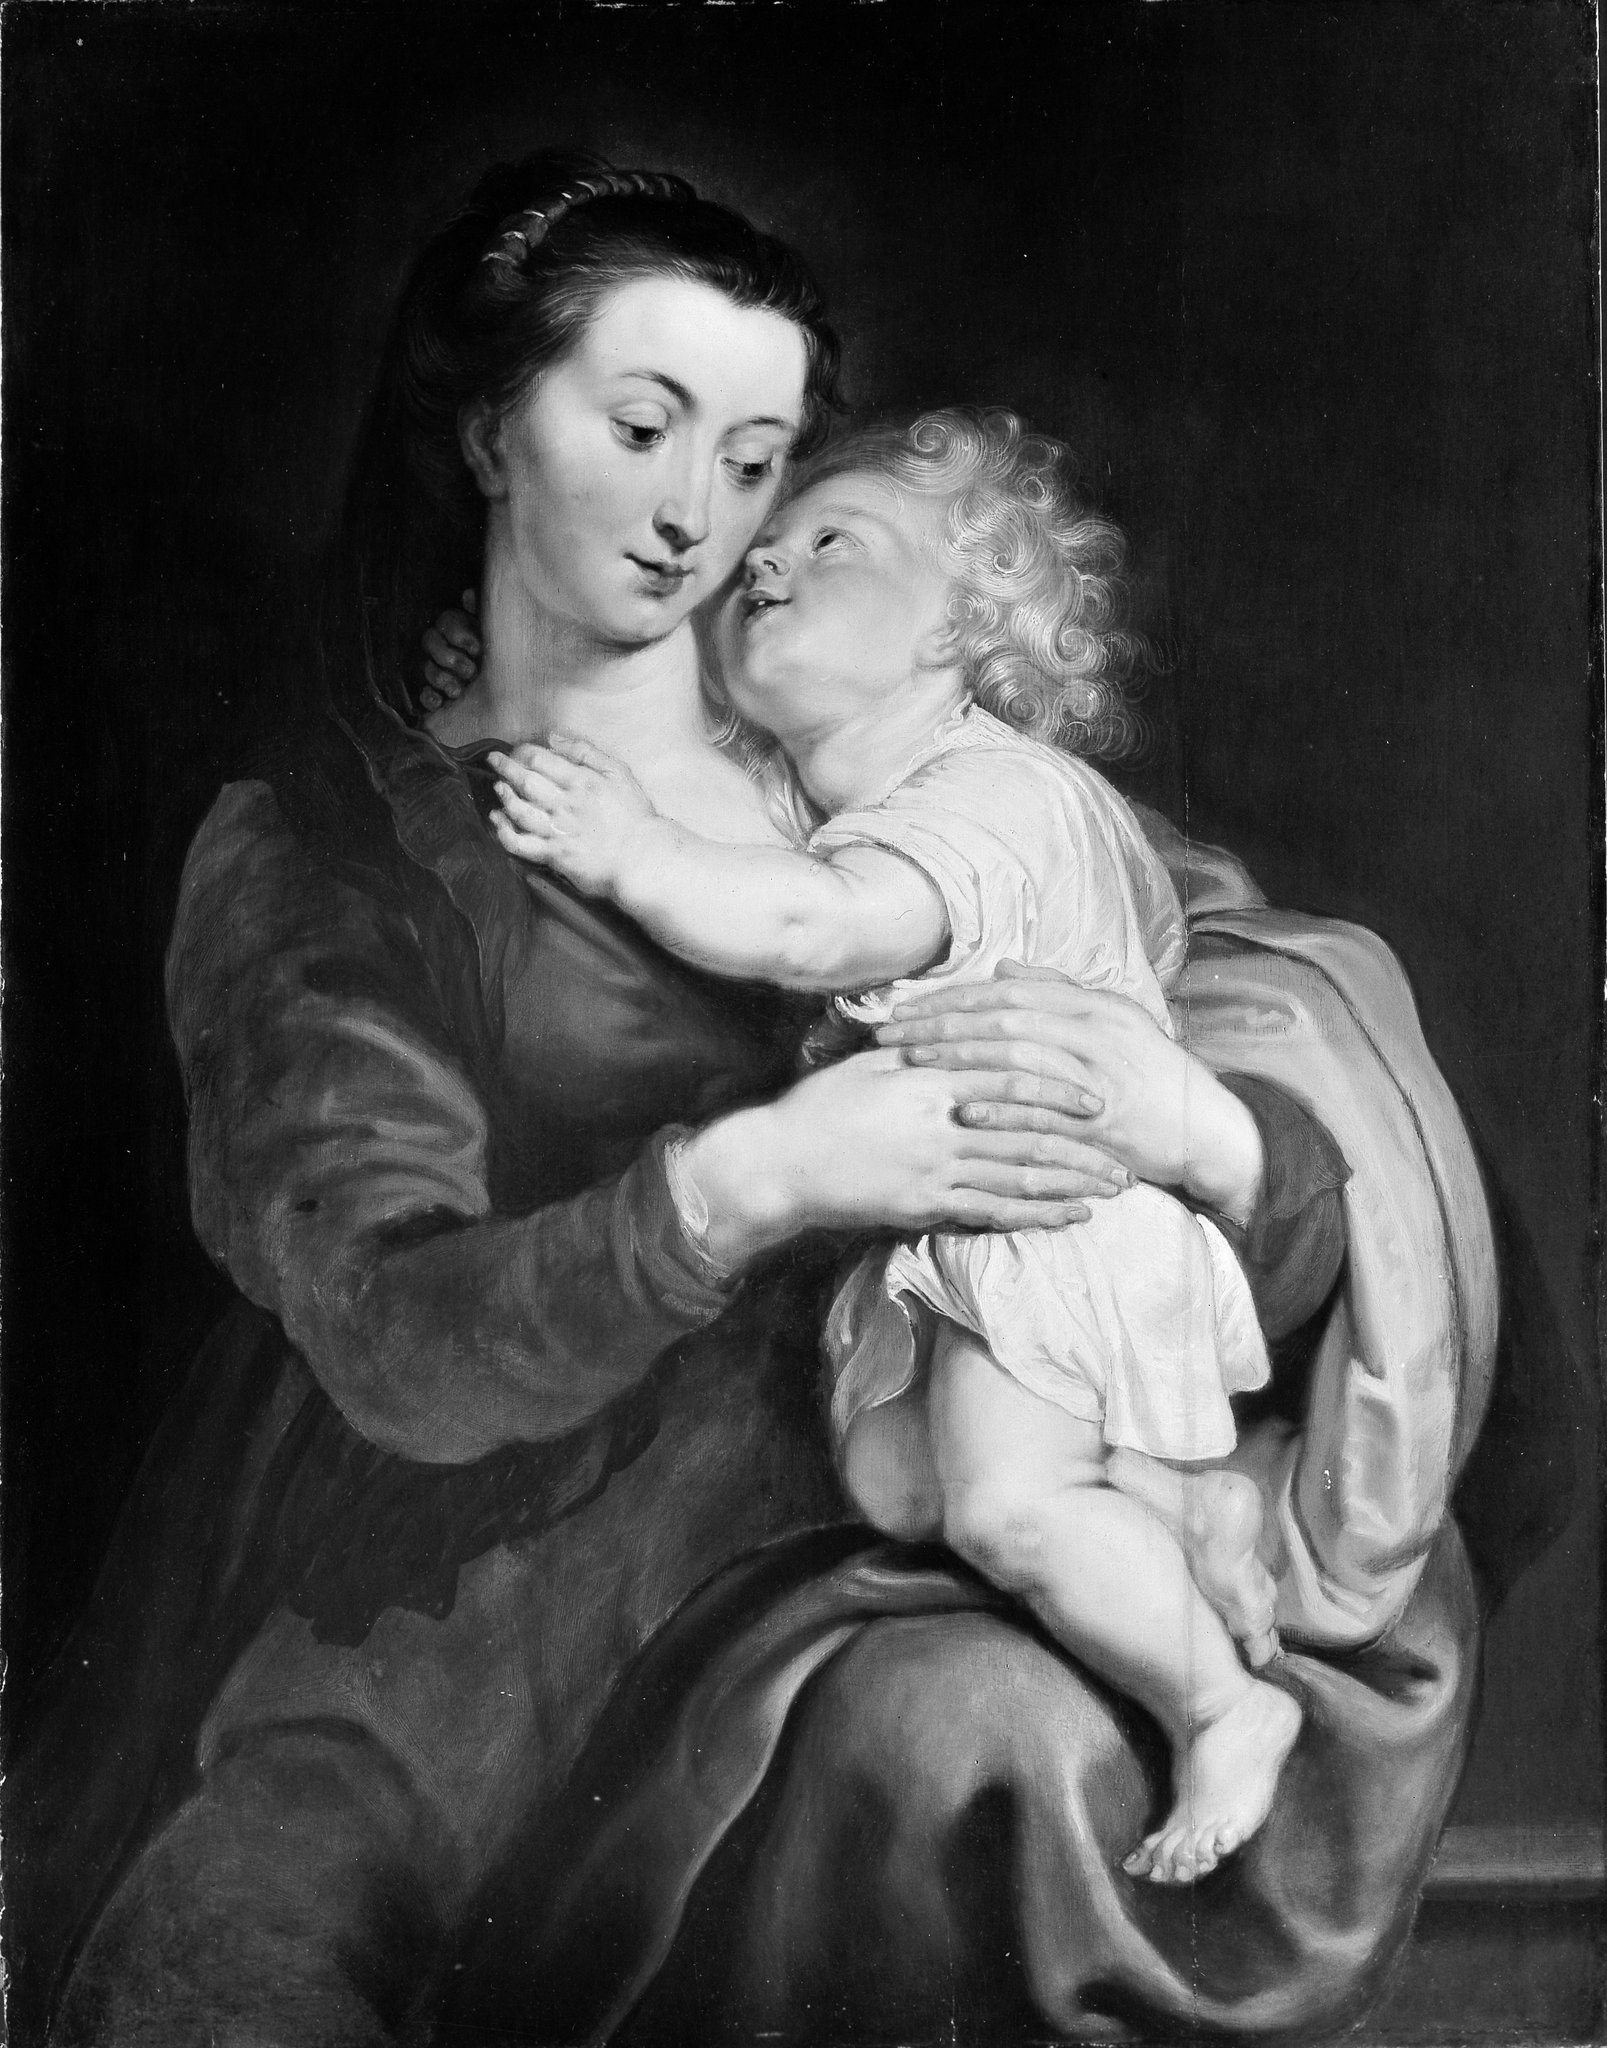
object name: painting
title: Virgin and Child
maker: peter paul rubens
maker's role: artist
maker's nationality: flemish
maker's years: 1577-1640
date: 1597-1640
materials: oil, wood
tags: madonna and child